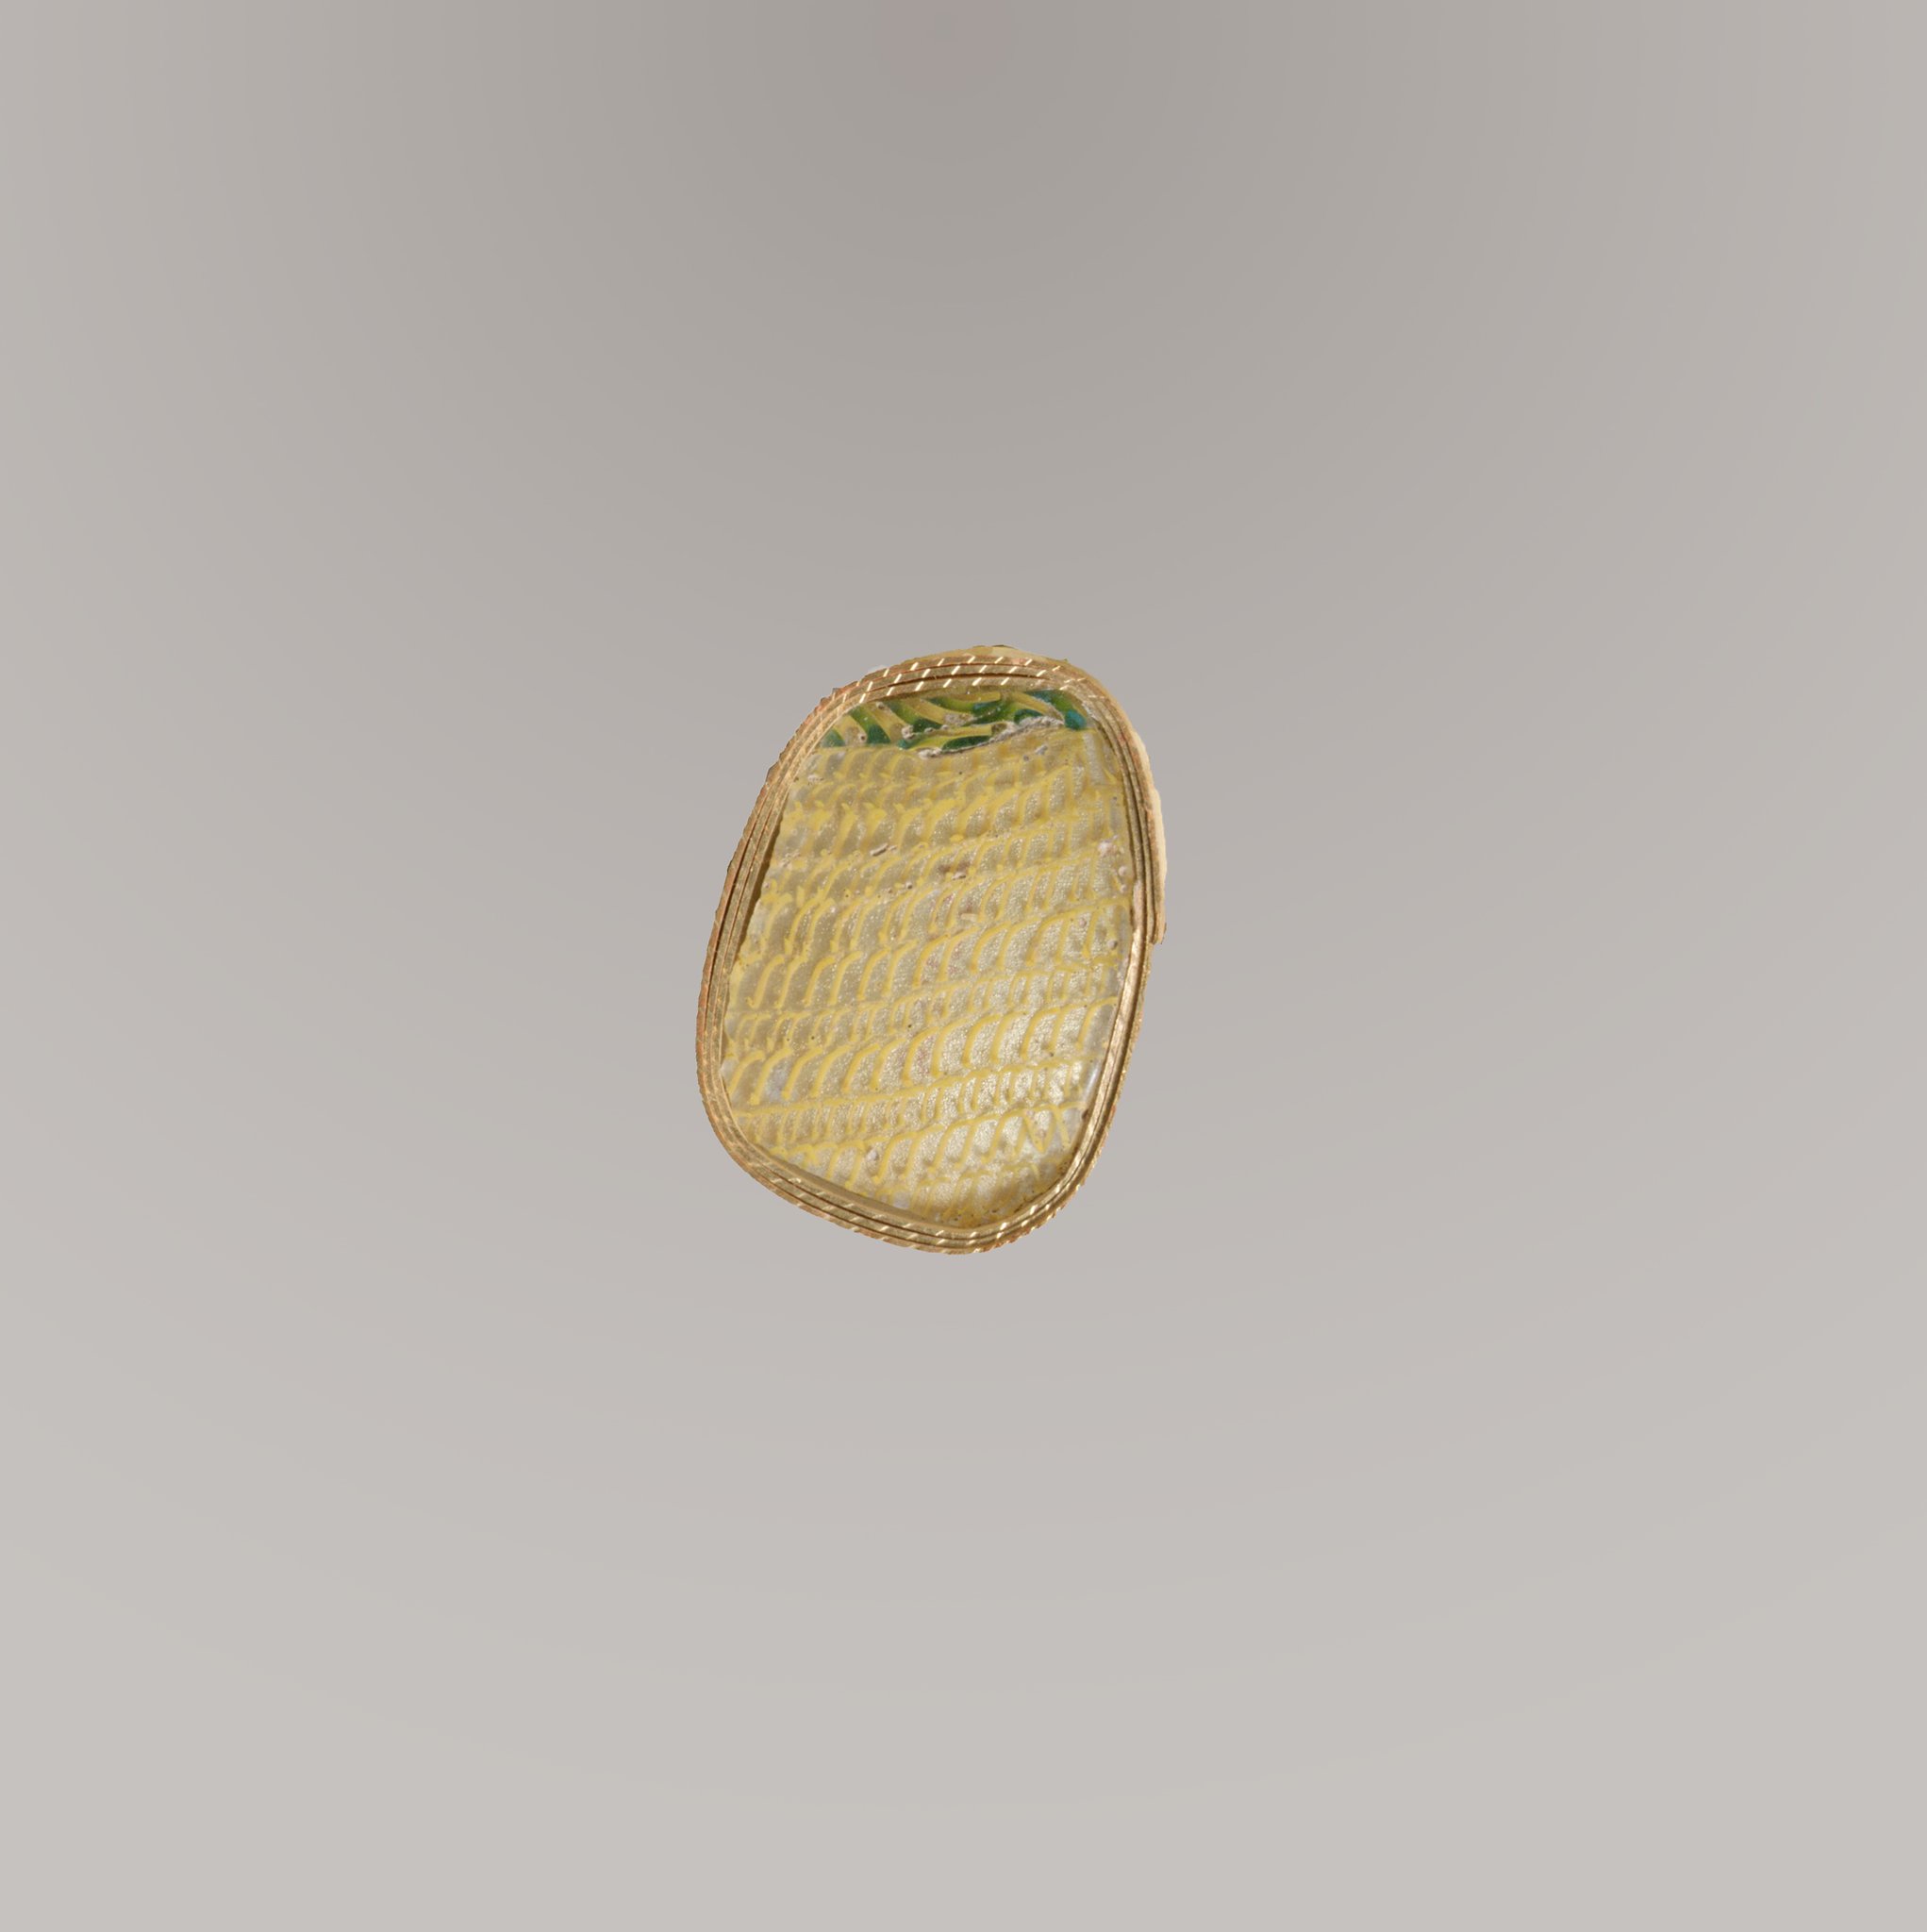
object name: fragment, network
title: Glass network mosaic fragment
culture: roman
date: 34 BCE-33 CE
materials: glass